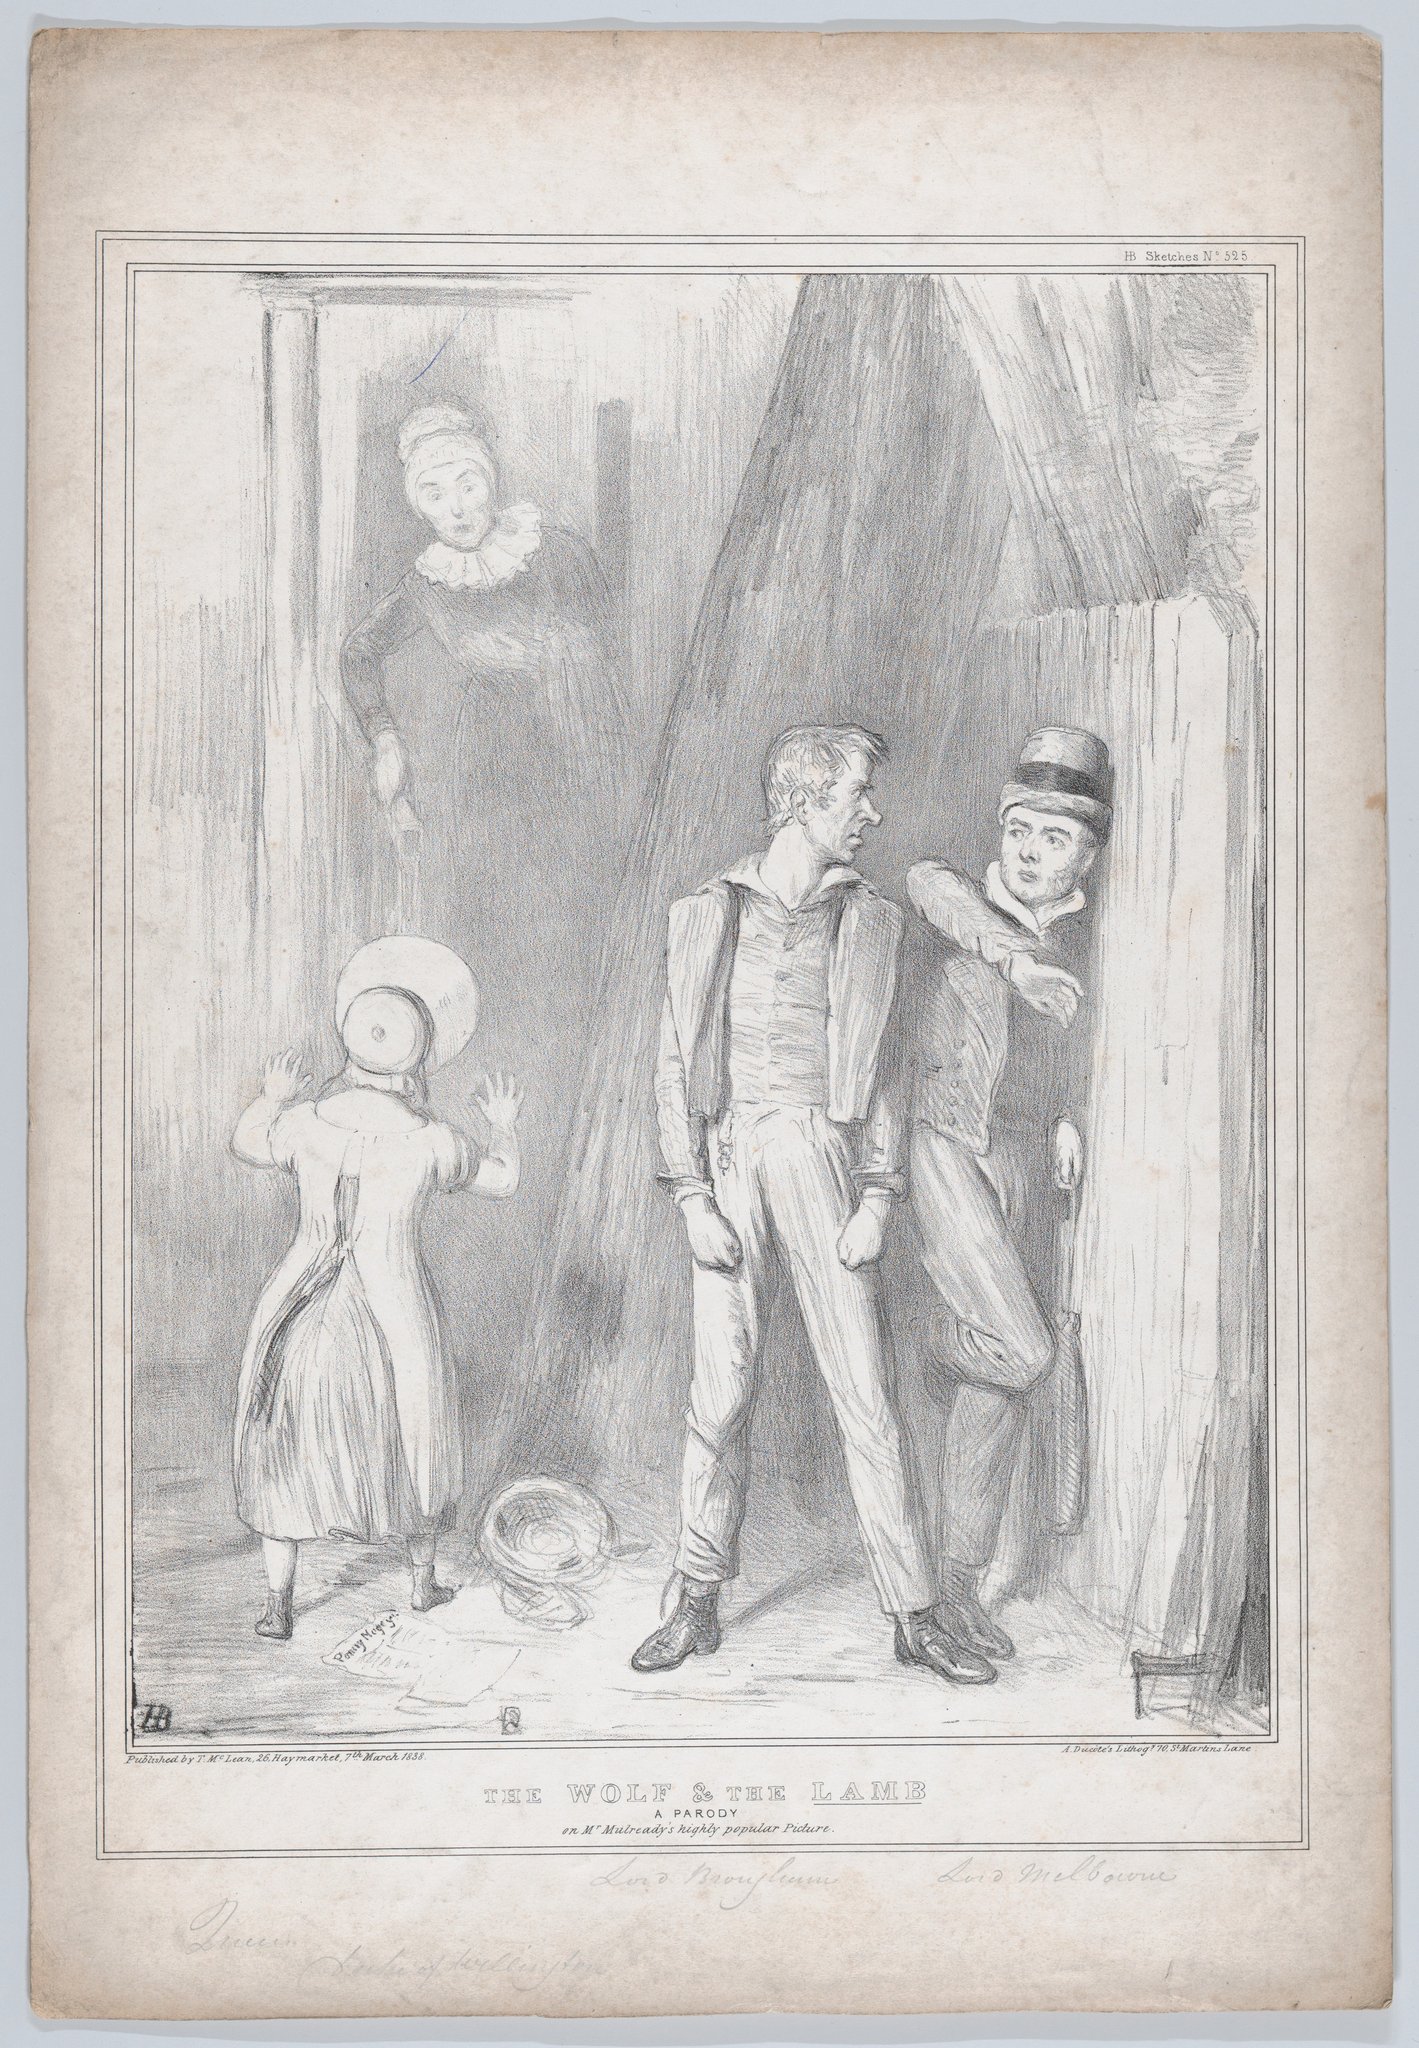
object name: print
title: The Wolf & the Lamb – A Parody on Mr. Mulready's highly popular Picture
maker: john doyle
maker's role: artist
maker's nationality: irish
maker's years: 1797-1868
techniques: lithograph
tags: men,women